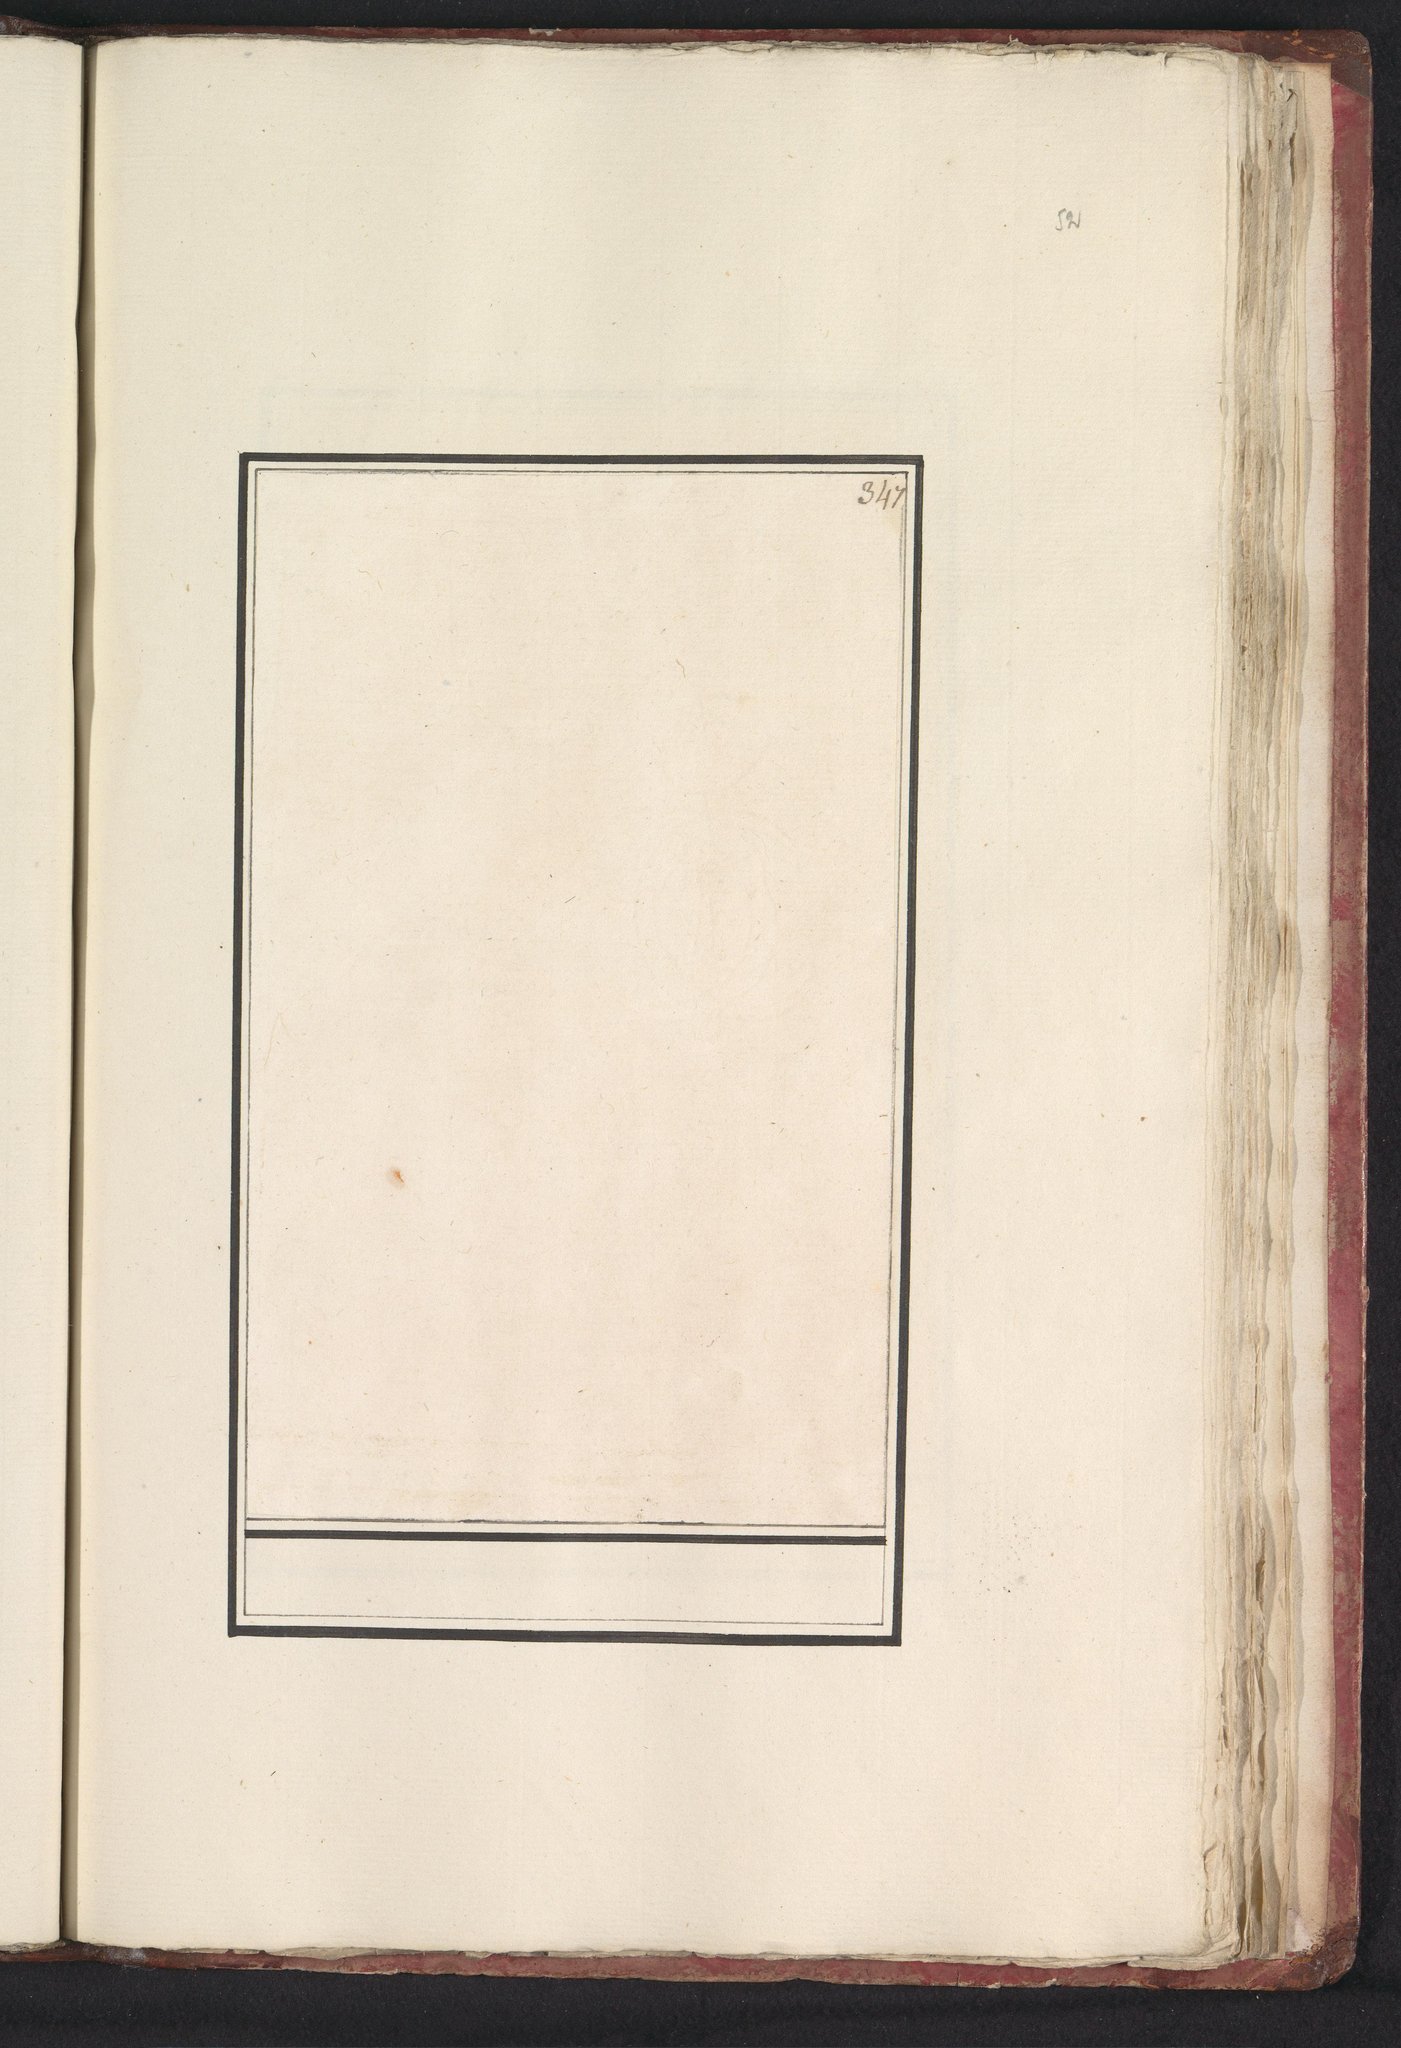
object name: drawing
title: Omlijsting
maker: Anonymous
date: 1809-1814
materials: paper, pencil, watercolor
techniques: brush, pen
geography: southern netherlands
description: Lege omlijsting. Rechtsboven genummerd: 347. Onderdeel van het vierde album met tekeningen van bloemen en paddestoelen. Elfde van twaalf albums met tekeningen van dieren, vogels en planten bekend rond 1600, gemaakt in opdracht van keizer Rudolf II. Met toelichting in Nederlands, Latijn en Frans.